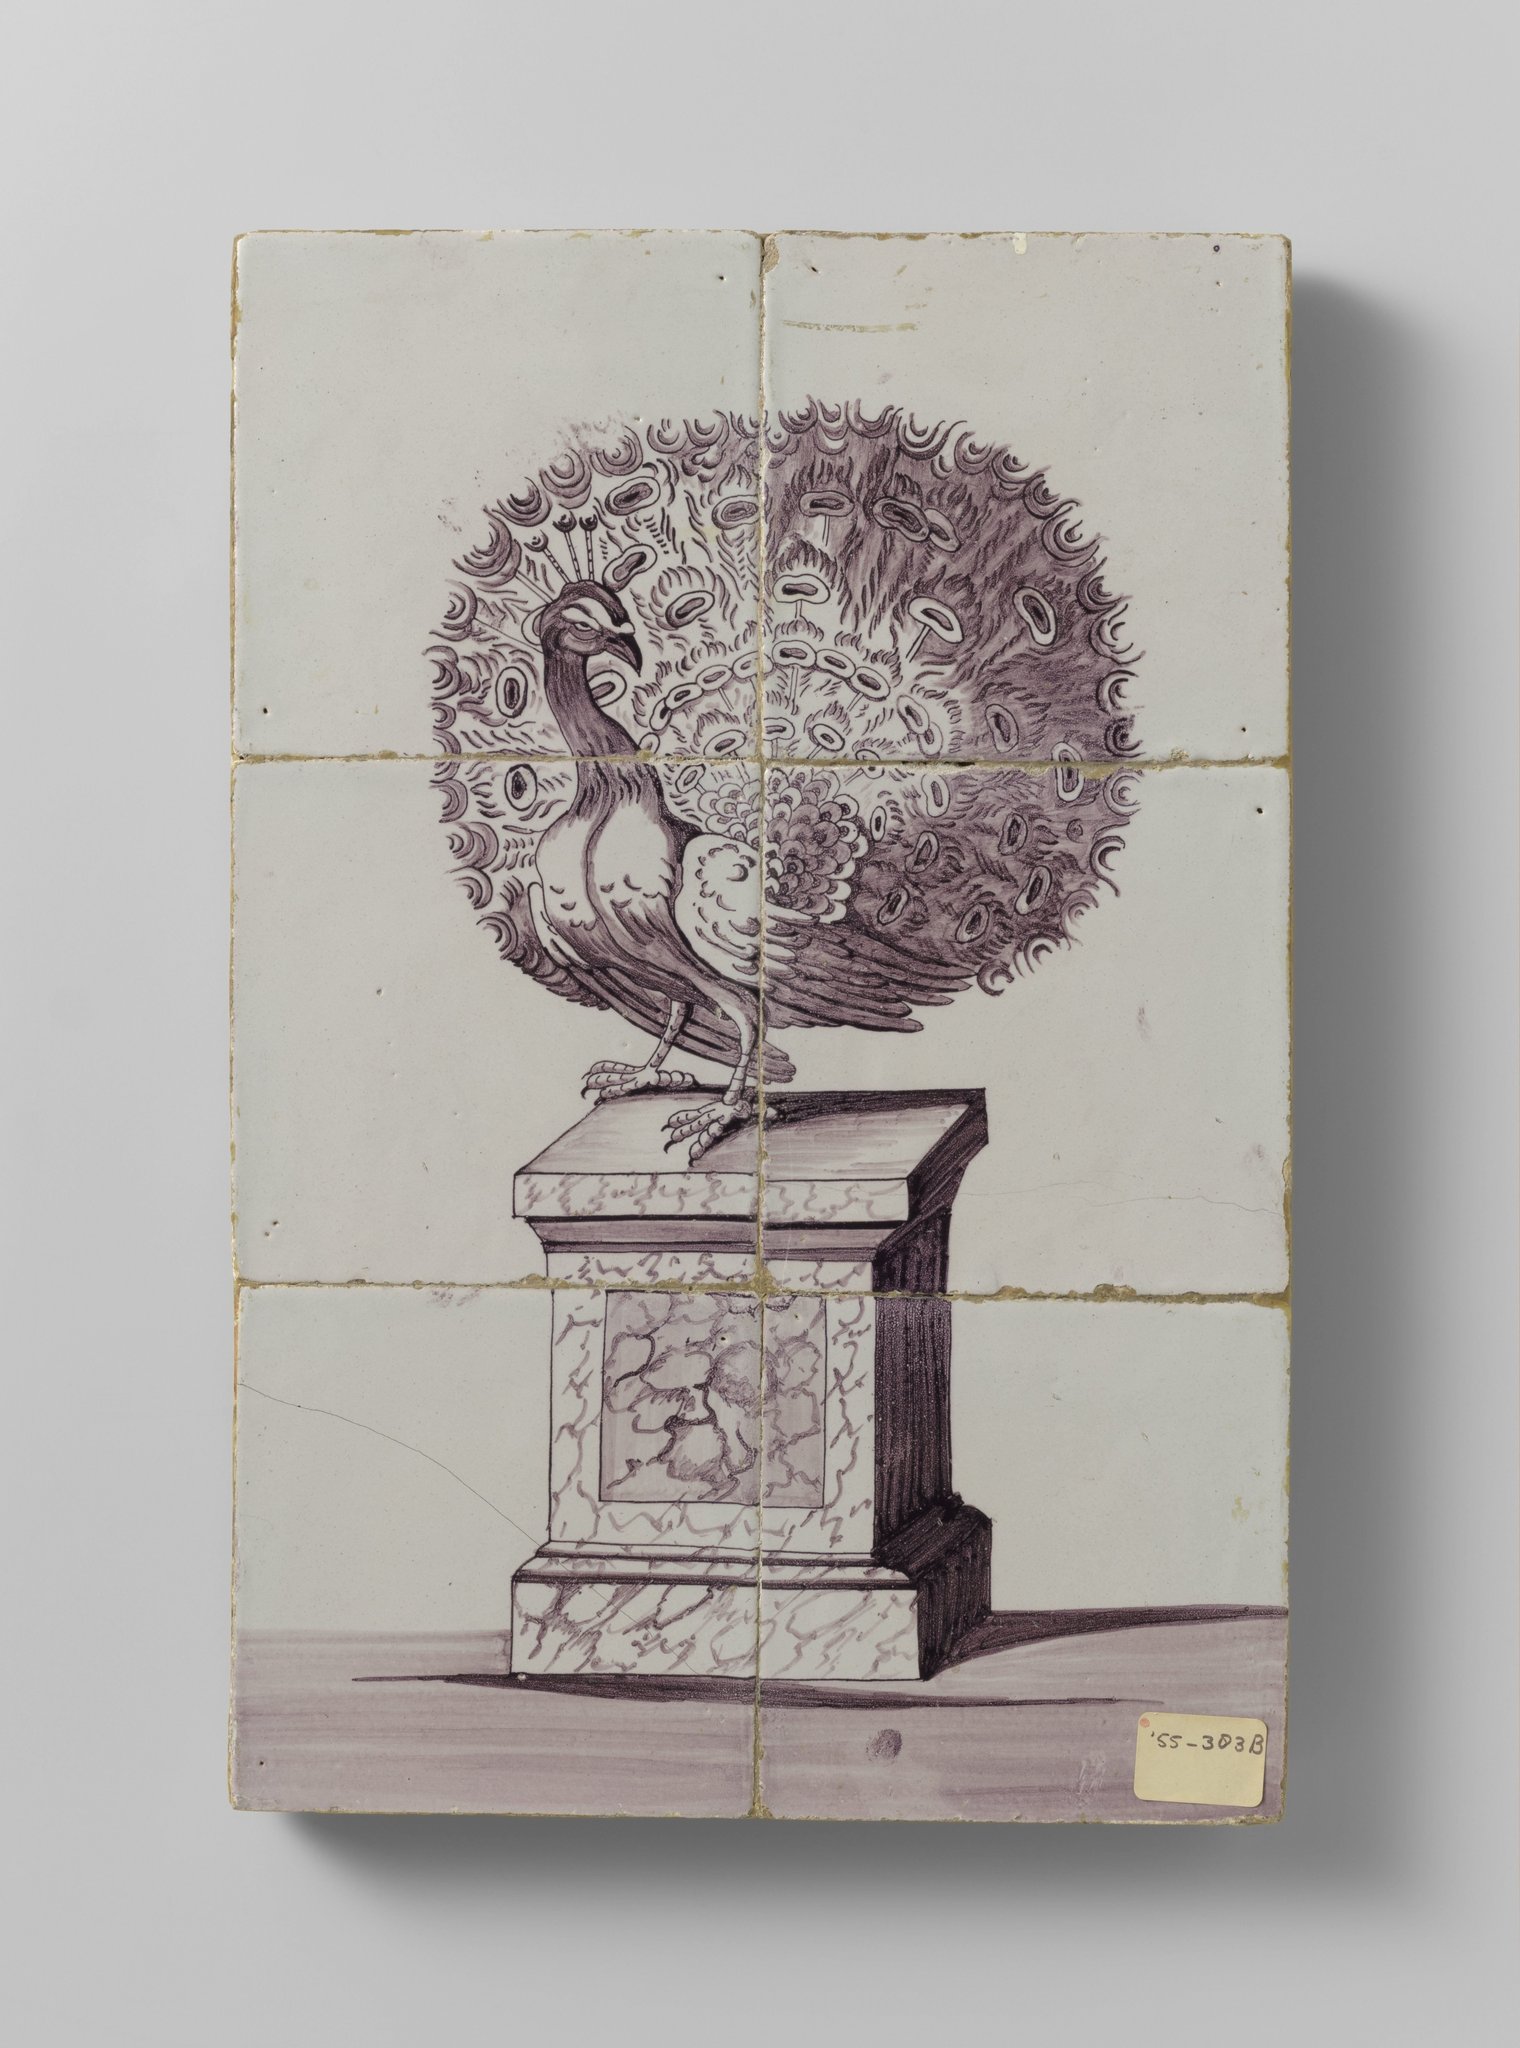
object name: tile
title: Tegeltableau met pauw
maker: Anonymous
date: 1750-1800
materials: earthenware, glaze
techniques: maiolica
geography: netherlands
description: Tegeltableau van zes tegels (3 x 2) met een paars geschilderde pauw naar links op een vierkant gemarmerd voetstuk.